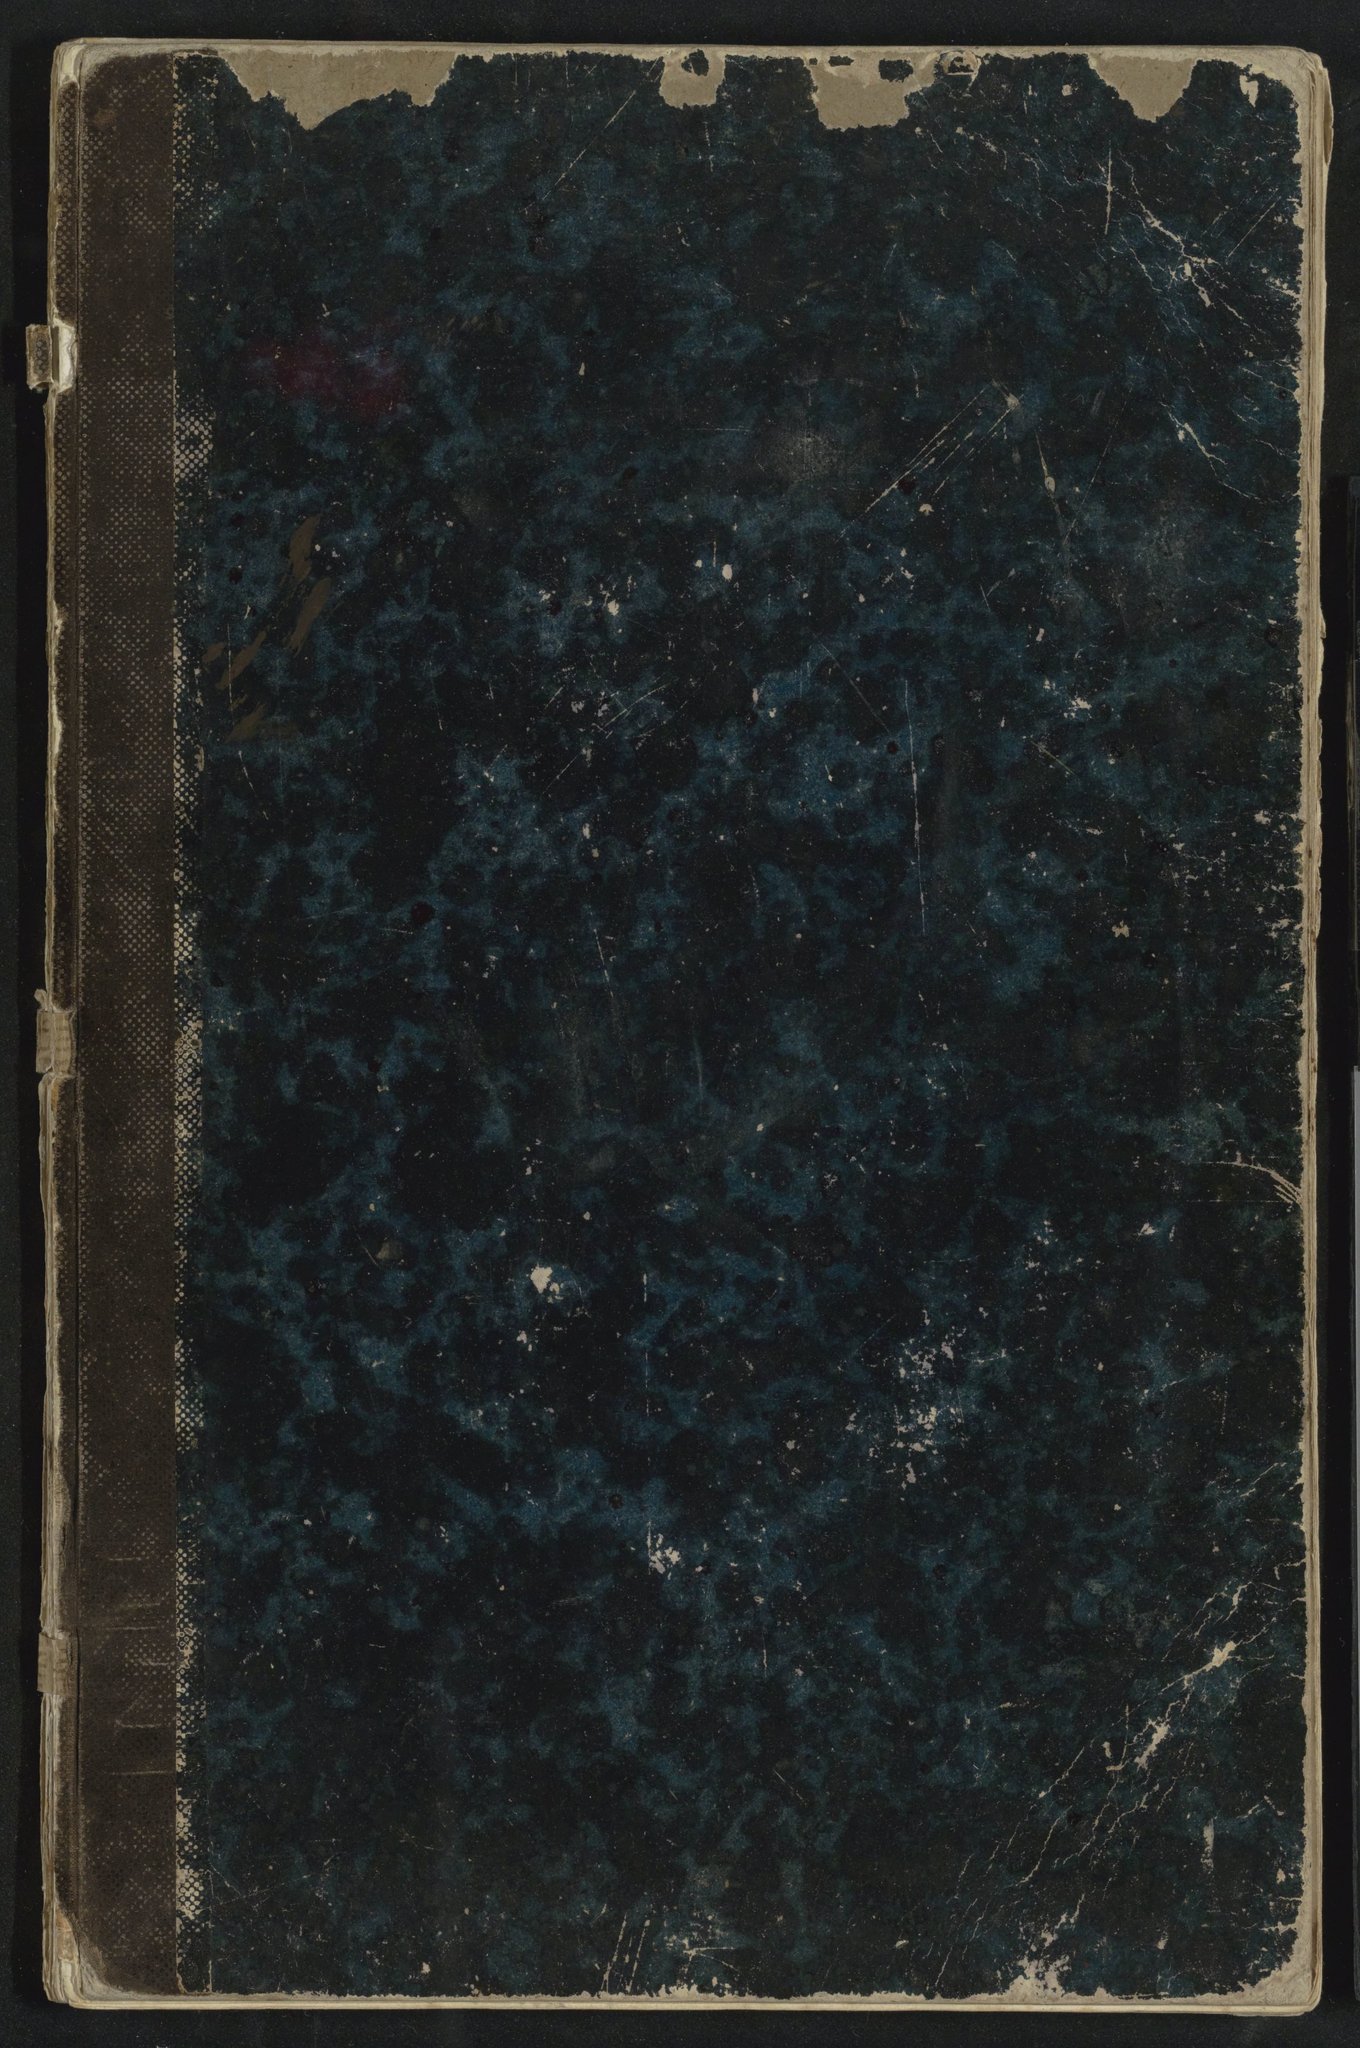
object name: sketchbook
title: Schetsboek met 42 bladen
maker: willem koekkoek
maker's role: draughtsman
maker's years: 1839-1895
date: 1849-1895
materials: cardboard, linen, paper, pencil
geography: eemland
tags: public road in village, public road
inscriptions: collector's mark: Lugt 2228a, annotation: ‘W. Koekkoek sketches/ my grandfather/ Spakenburg/ Bunschoten/ Amersfoort/ Culemborg/ Ysselsteyn/ Vianen’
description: De volgende bladen uit het schetsboek zijn blanco: 1(V), 3(V), 5(V), 7(V) t/m 9(V), 12(V), 13(V), 14(R), 17(V), 18(R), 19(V), 21(R), 22(V), 25(R), 26(R), 27(R), 29(V), 30(R), 31(V), 33(R), 34(V), 37(R), 39(V) en 42(V).